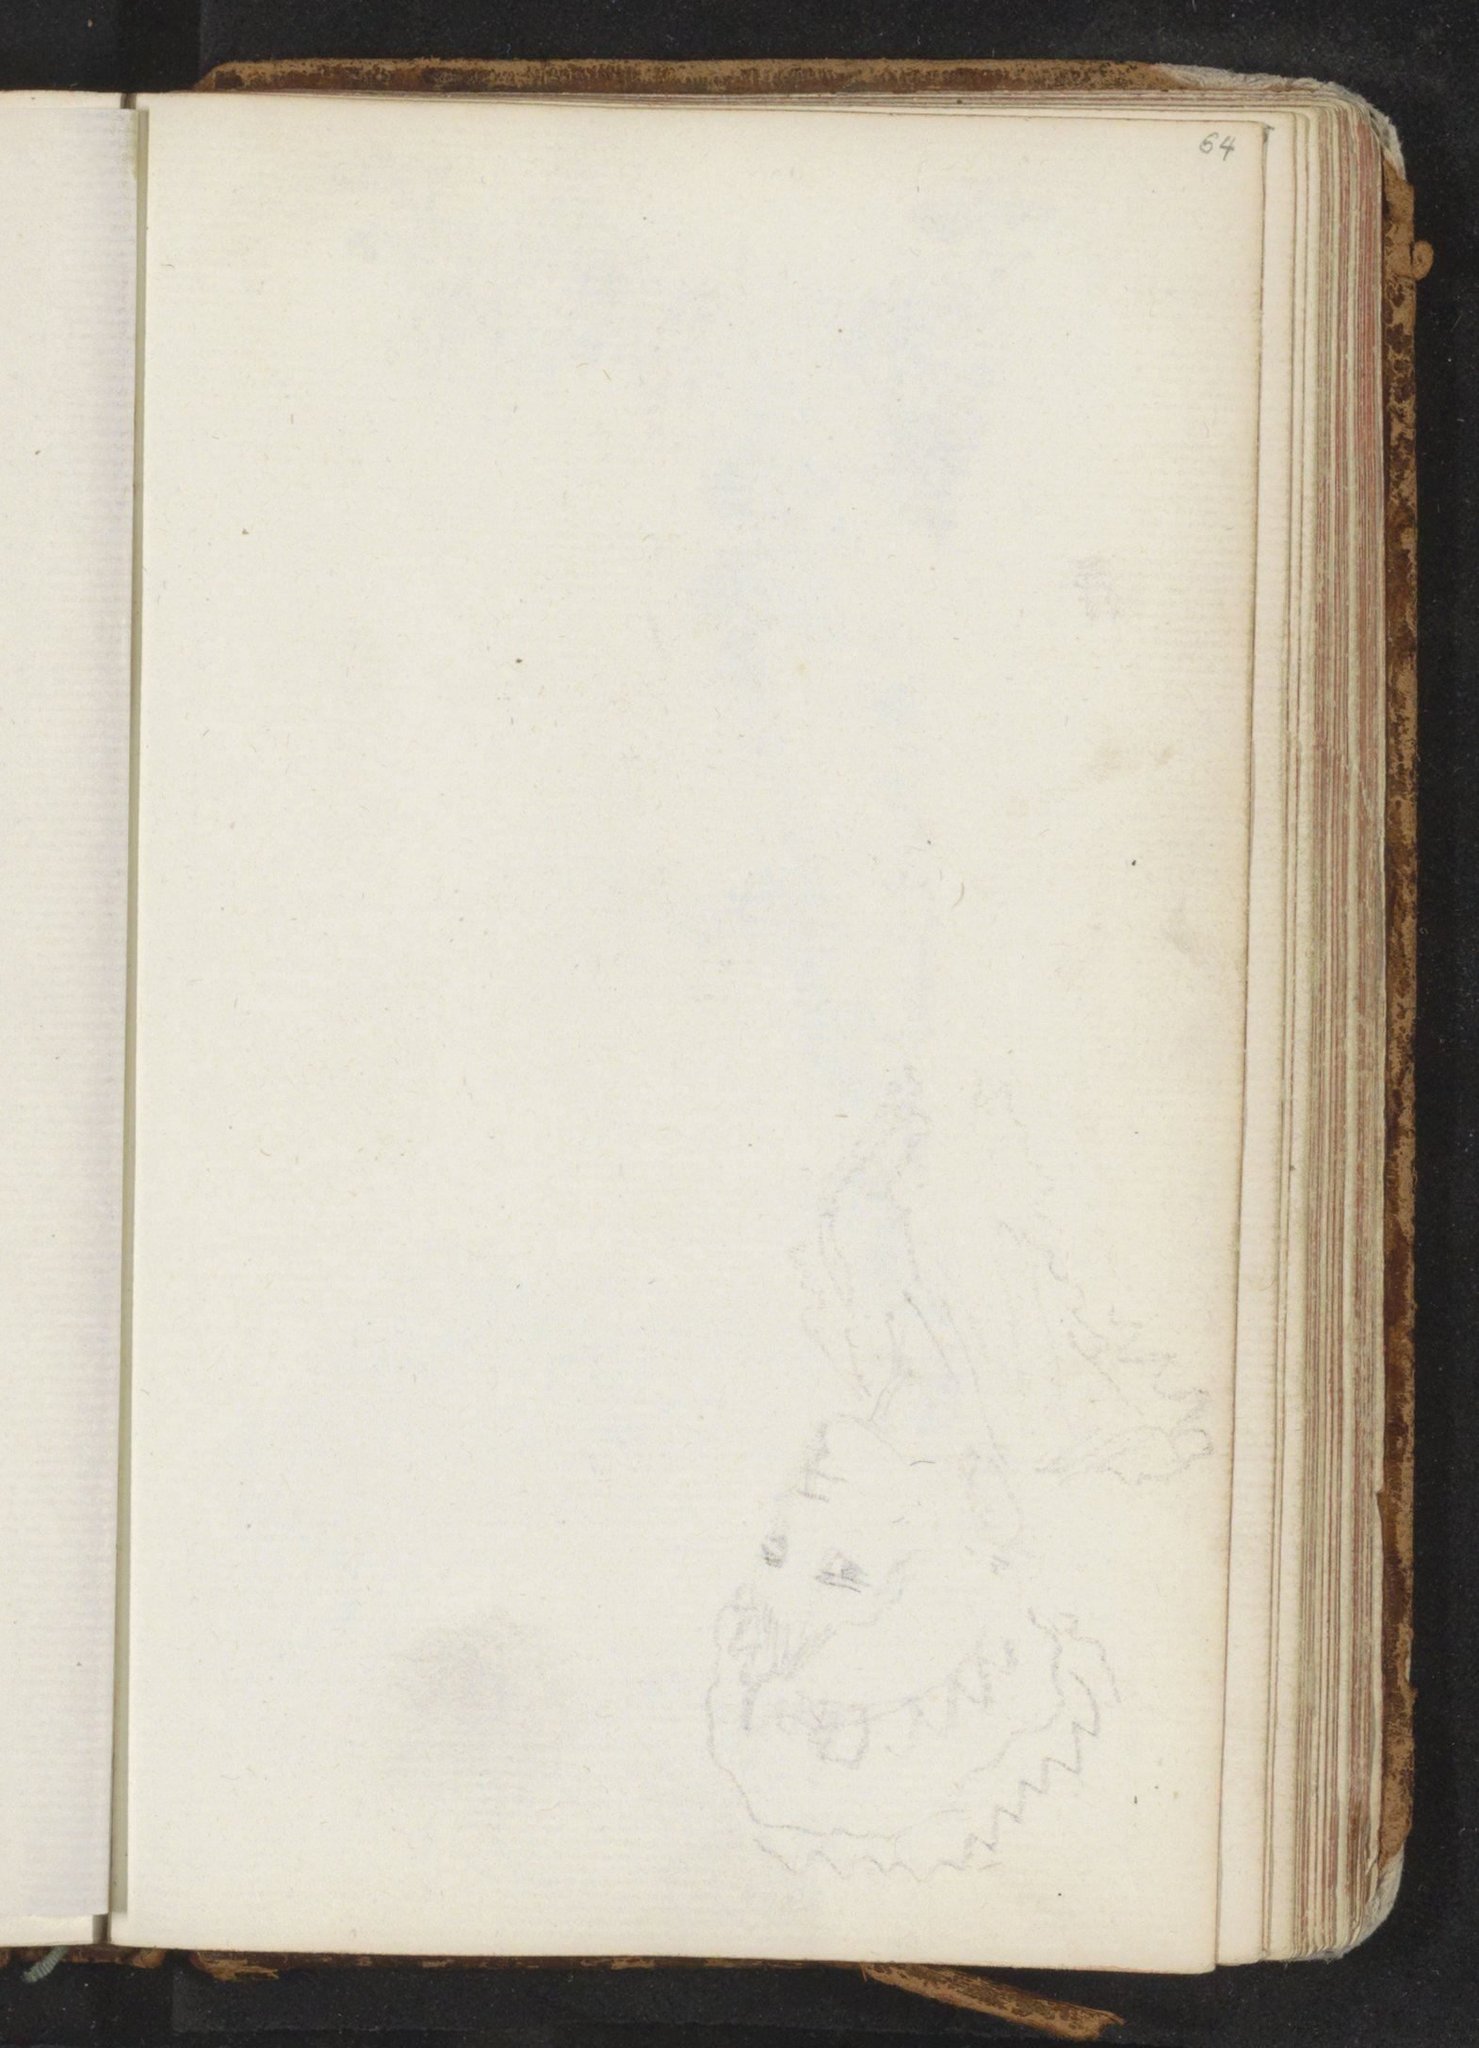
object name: sketchbook leaf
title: Kop van een vrouw met een met kant afgezette muts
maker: jean honoré fragonard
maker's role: draughtsman, painter, print maker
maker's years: 1732-1806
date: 1765-1775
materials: paper, pencil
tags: head (human), head-gear: cap (+ women's clothes)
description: Blad 64 recto uit een schetsboek met 83 bladen.